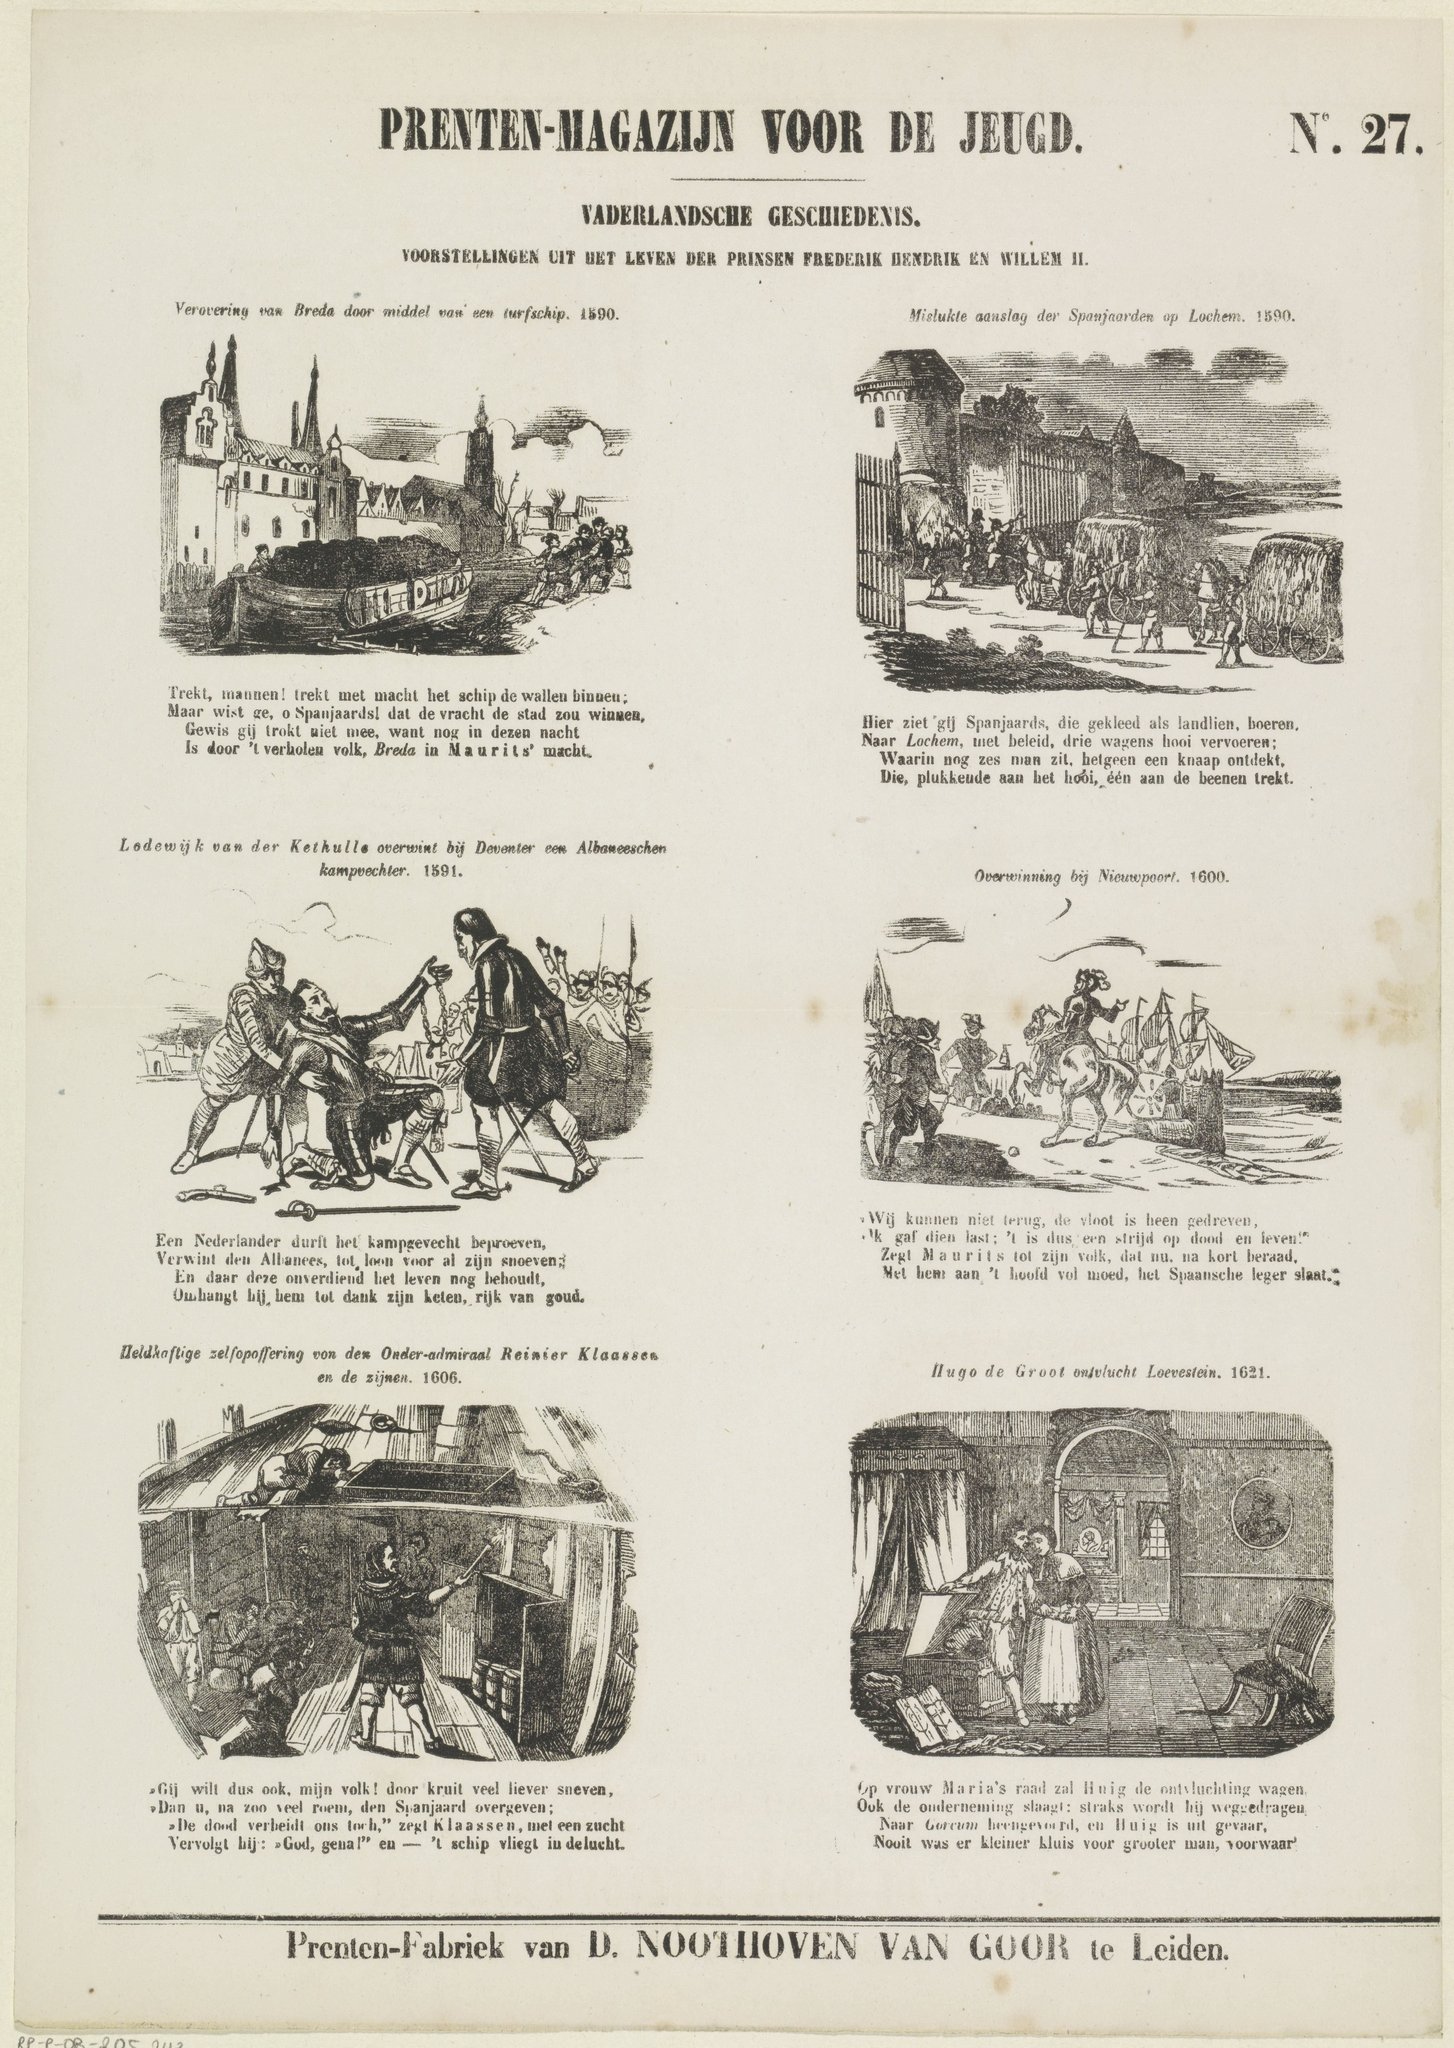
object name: popular print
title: Prenten-magazijn voor de jeugd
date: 1850-1881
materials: paper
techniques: letterpress printing, engraving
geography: netherlands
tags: delft, hugo de groot, history, loevestein castle, deventer, battle of nieuwpoort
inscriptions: collector's mark: Lugt 2760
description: Blad met 6 voorstellingen van gebeurtenissen uit de vaderlandse geschiedenis. Boven elke voorstelling een titel en onder elke voorstelling een vierregelig vers. Genummerd rechtsboven: No. 27.